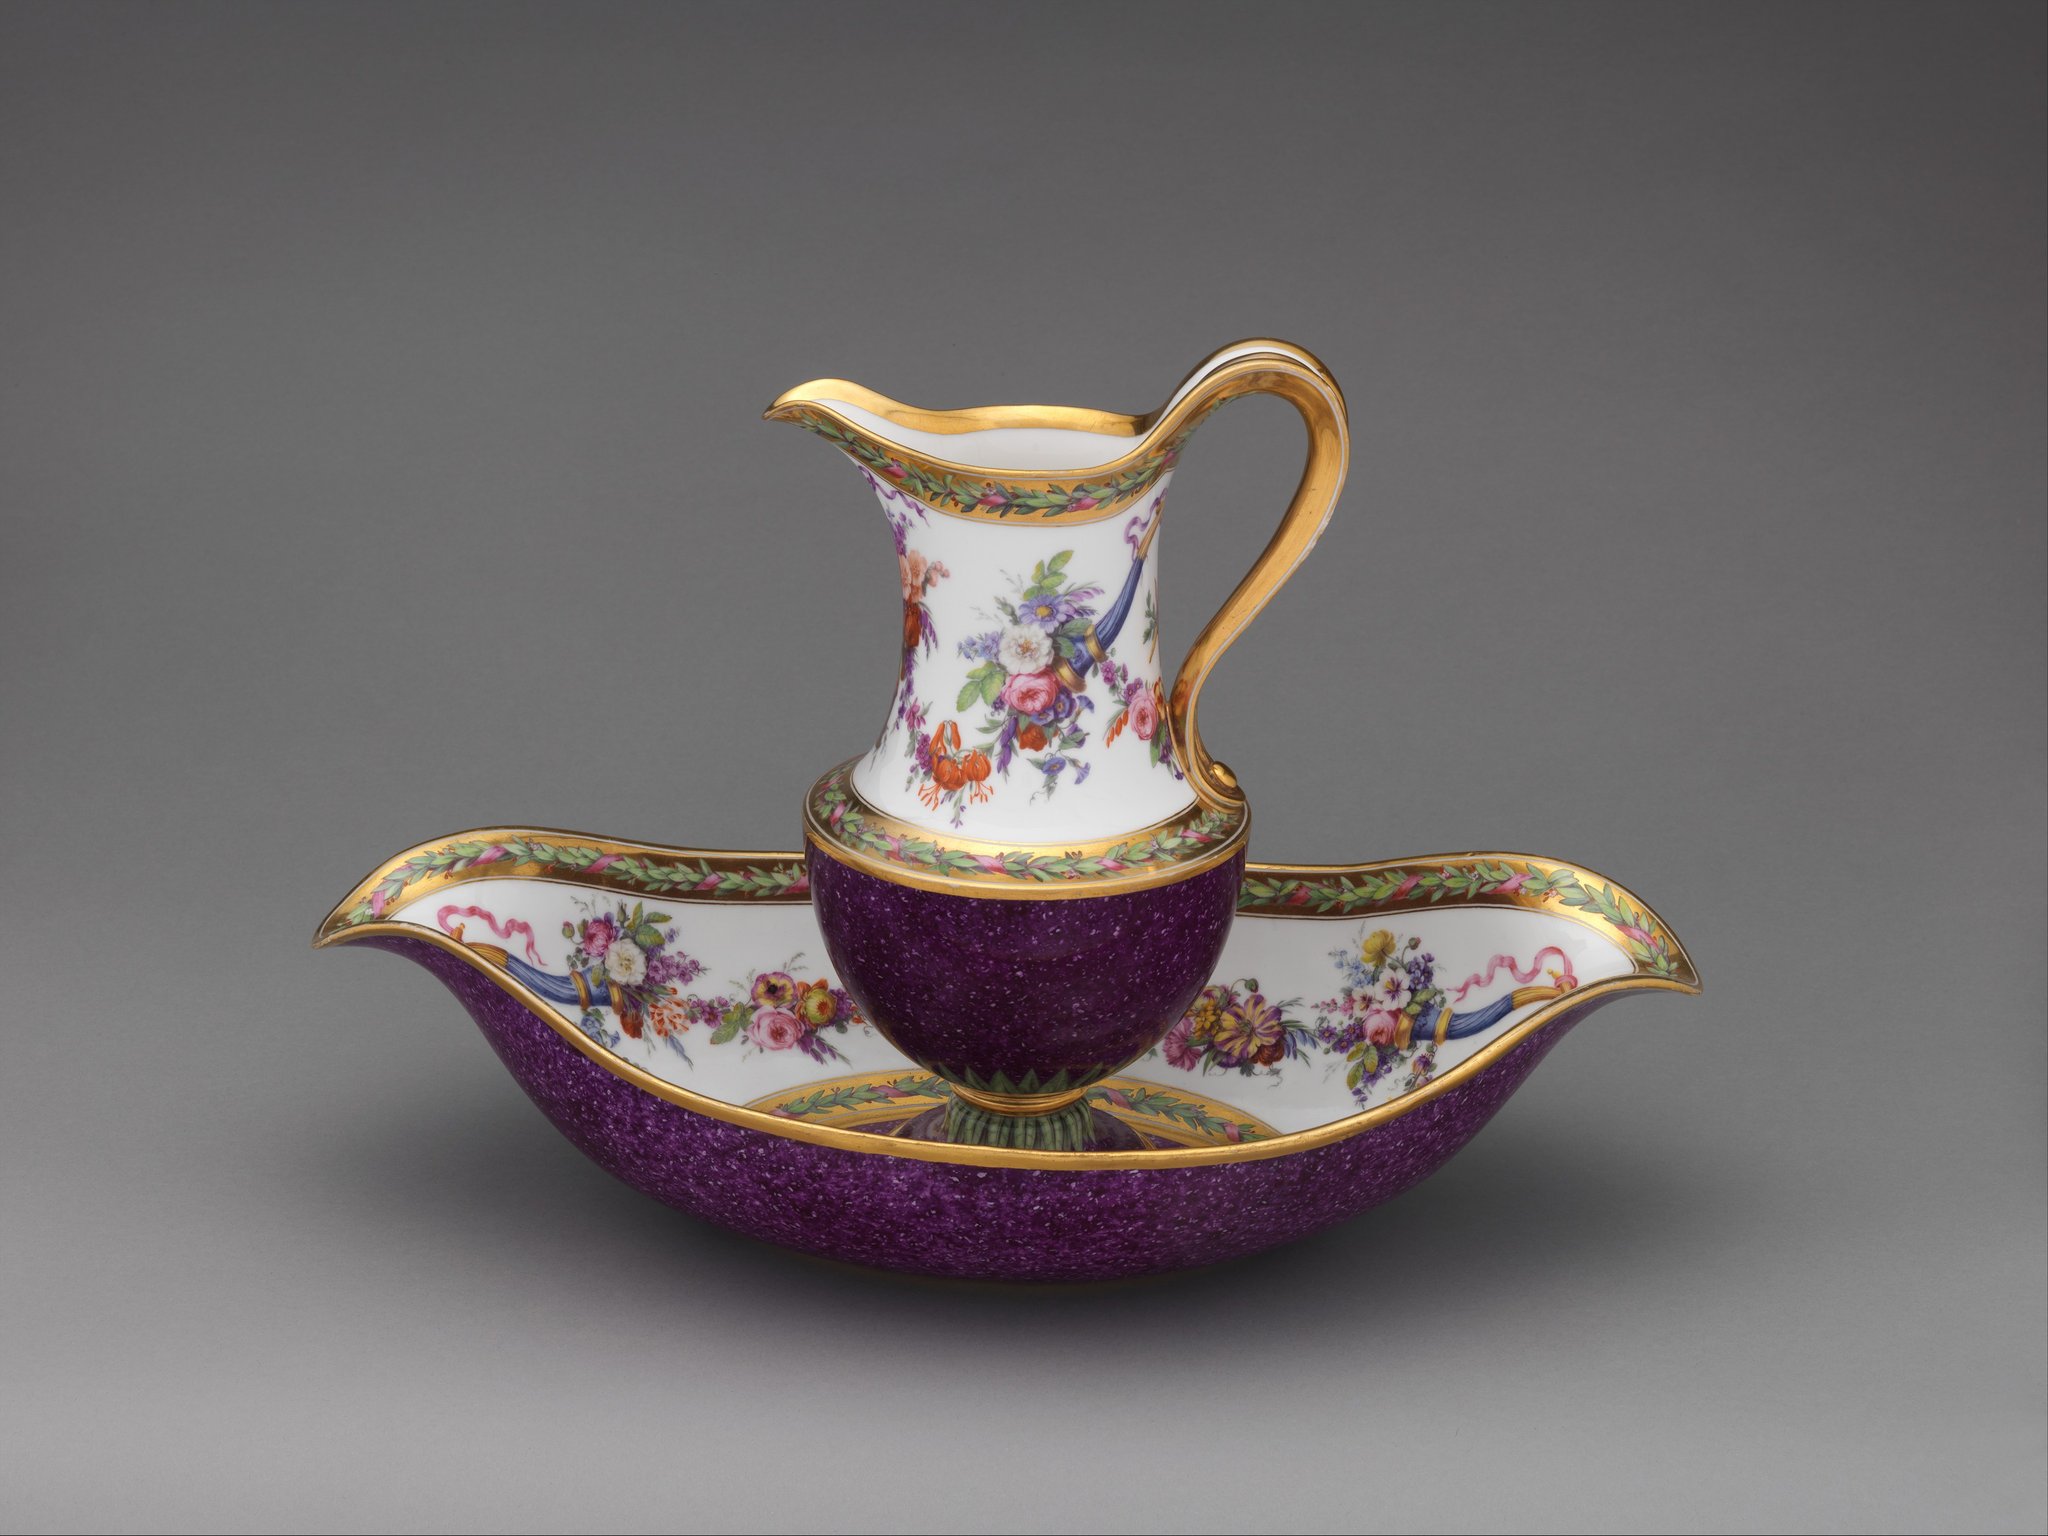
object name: ewer and basin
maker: sèvres manufactory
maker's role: manufactory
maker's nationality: french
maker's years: 1740-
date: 1795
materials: hard paste porcelain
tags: flowers